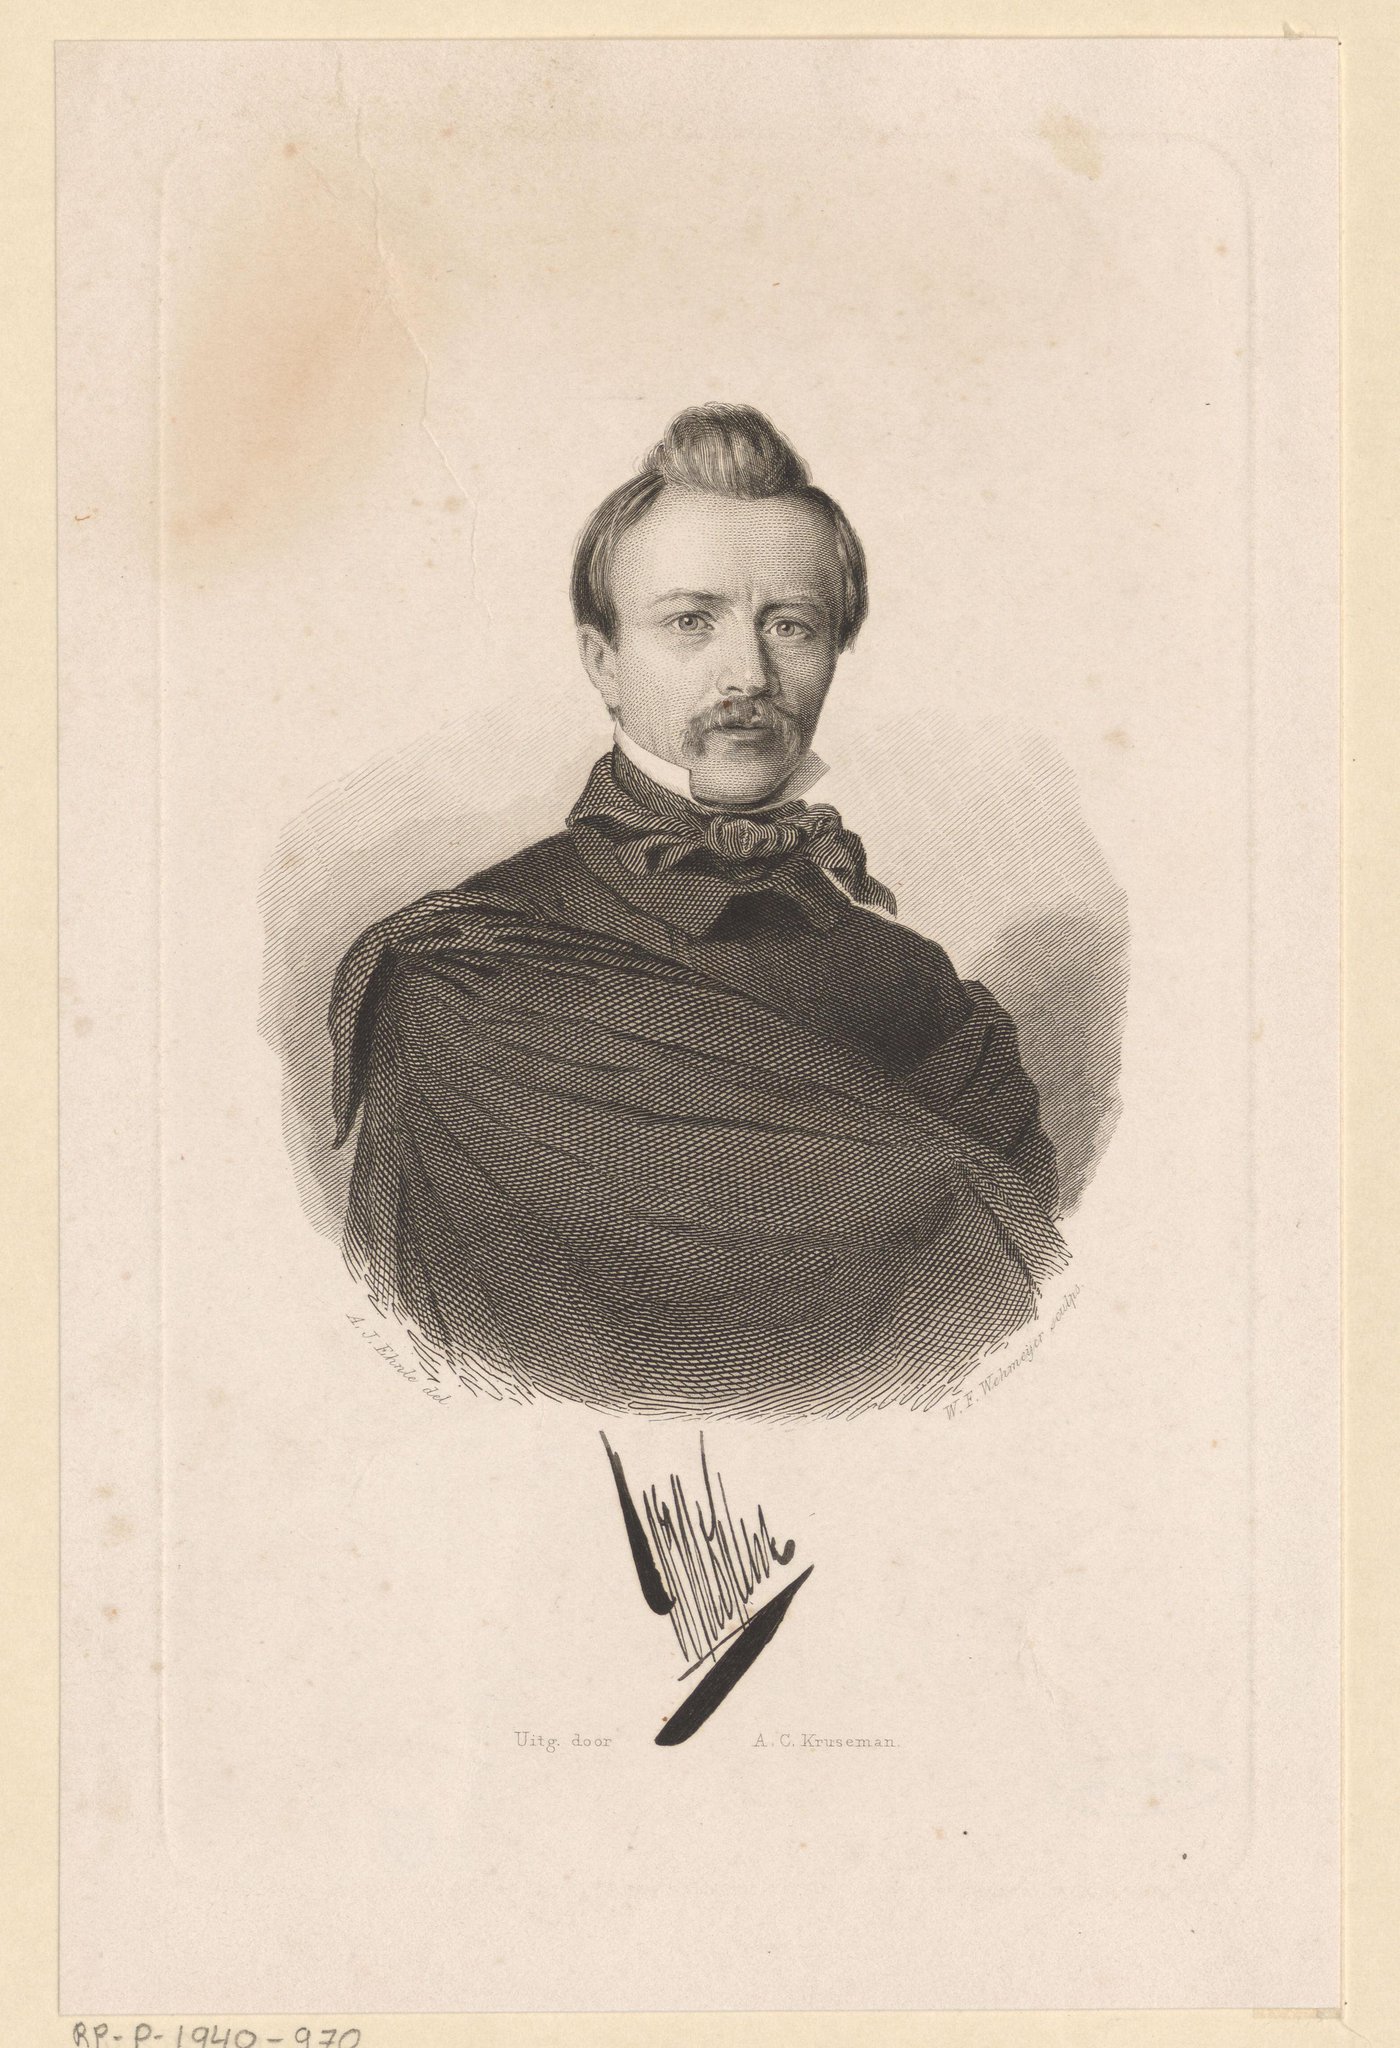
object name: print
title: Portret van Willem Jacobs Hofdijk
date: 1842-1854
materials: paper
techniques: engraving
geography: haarlem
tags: historical persons, writer, poet, author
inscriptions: collector's mark: Lugt 2228, collector's mark: Lugt 2760